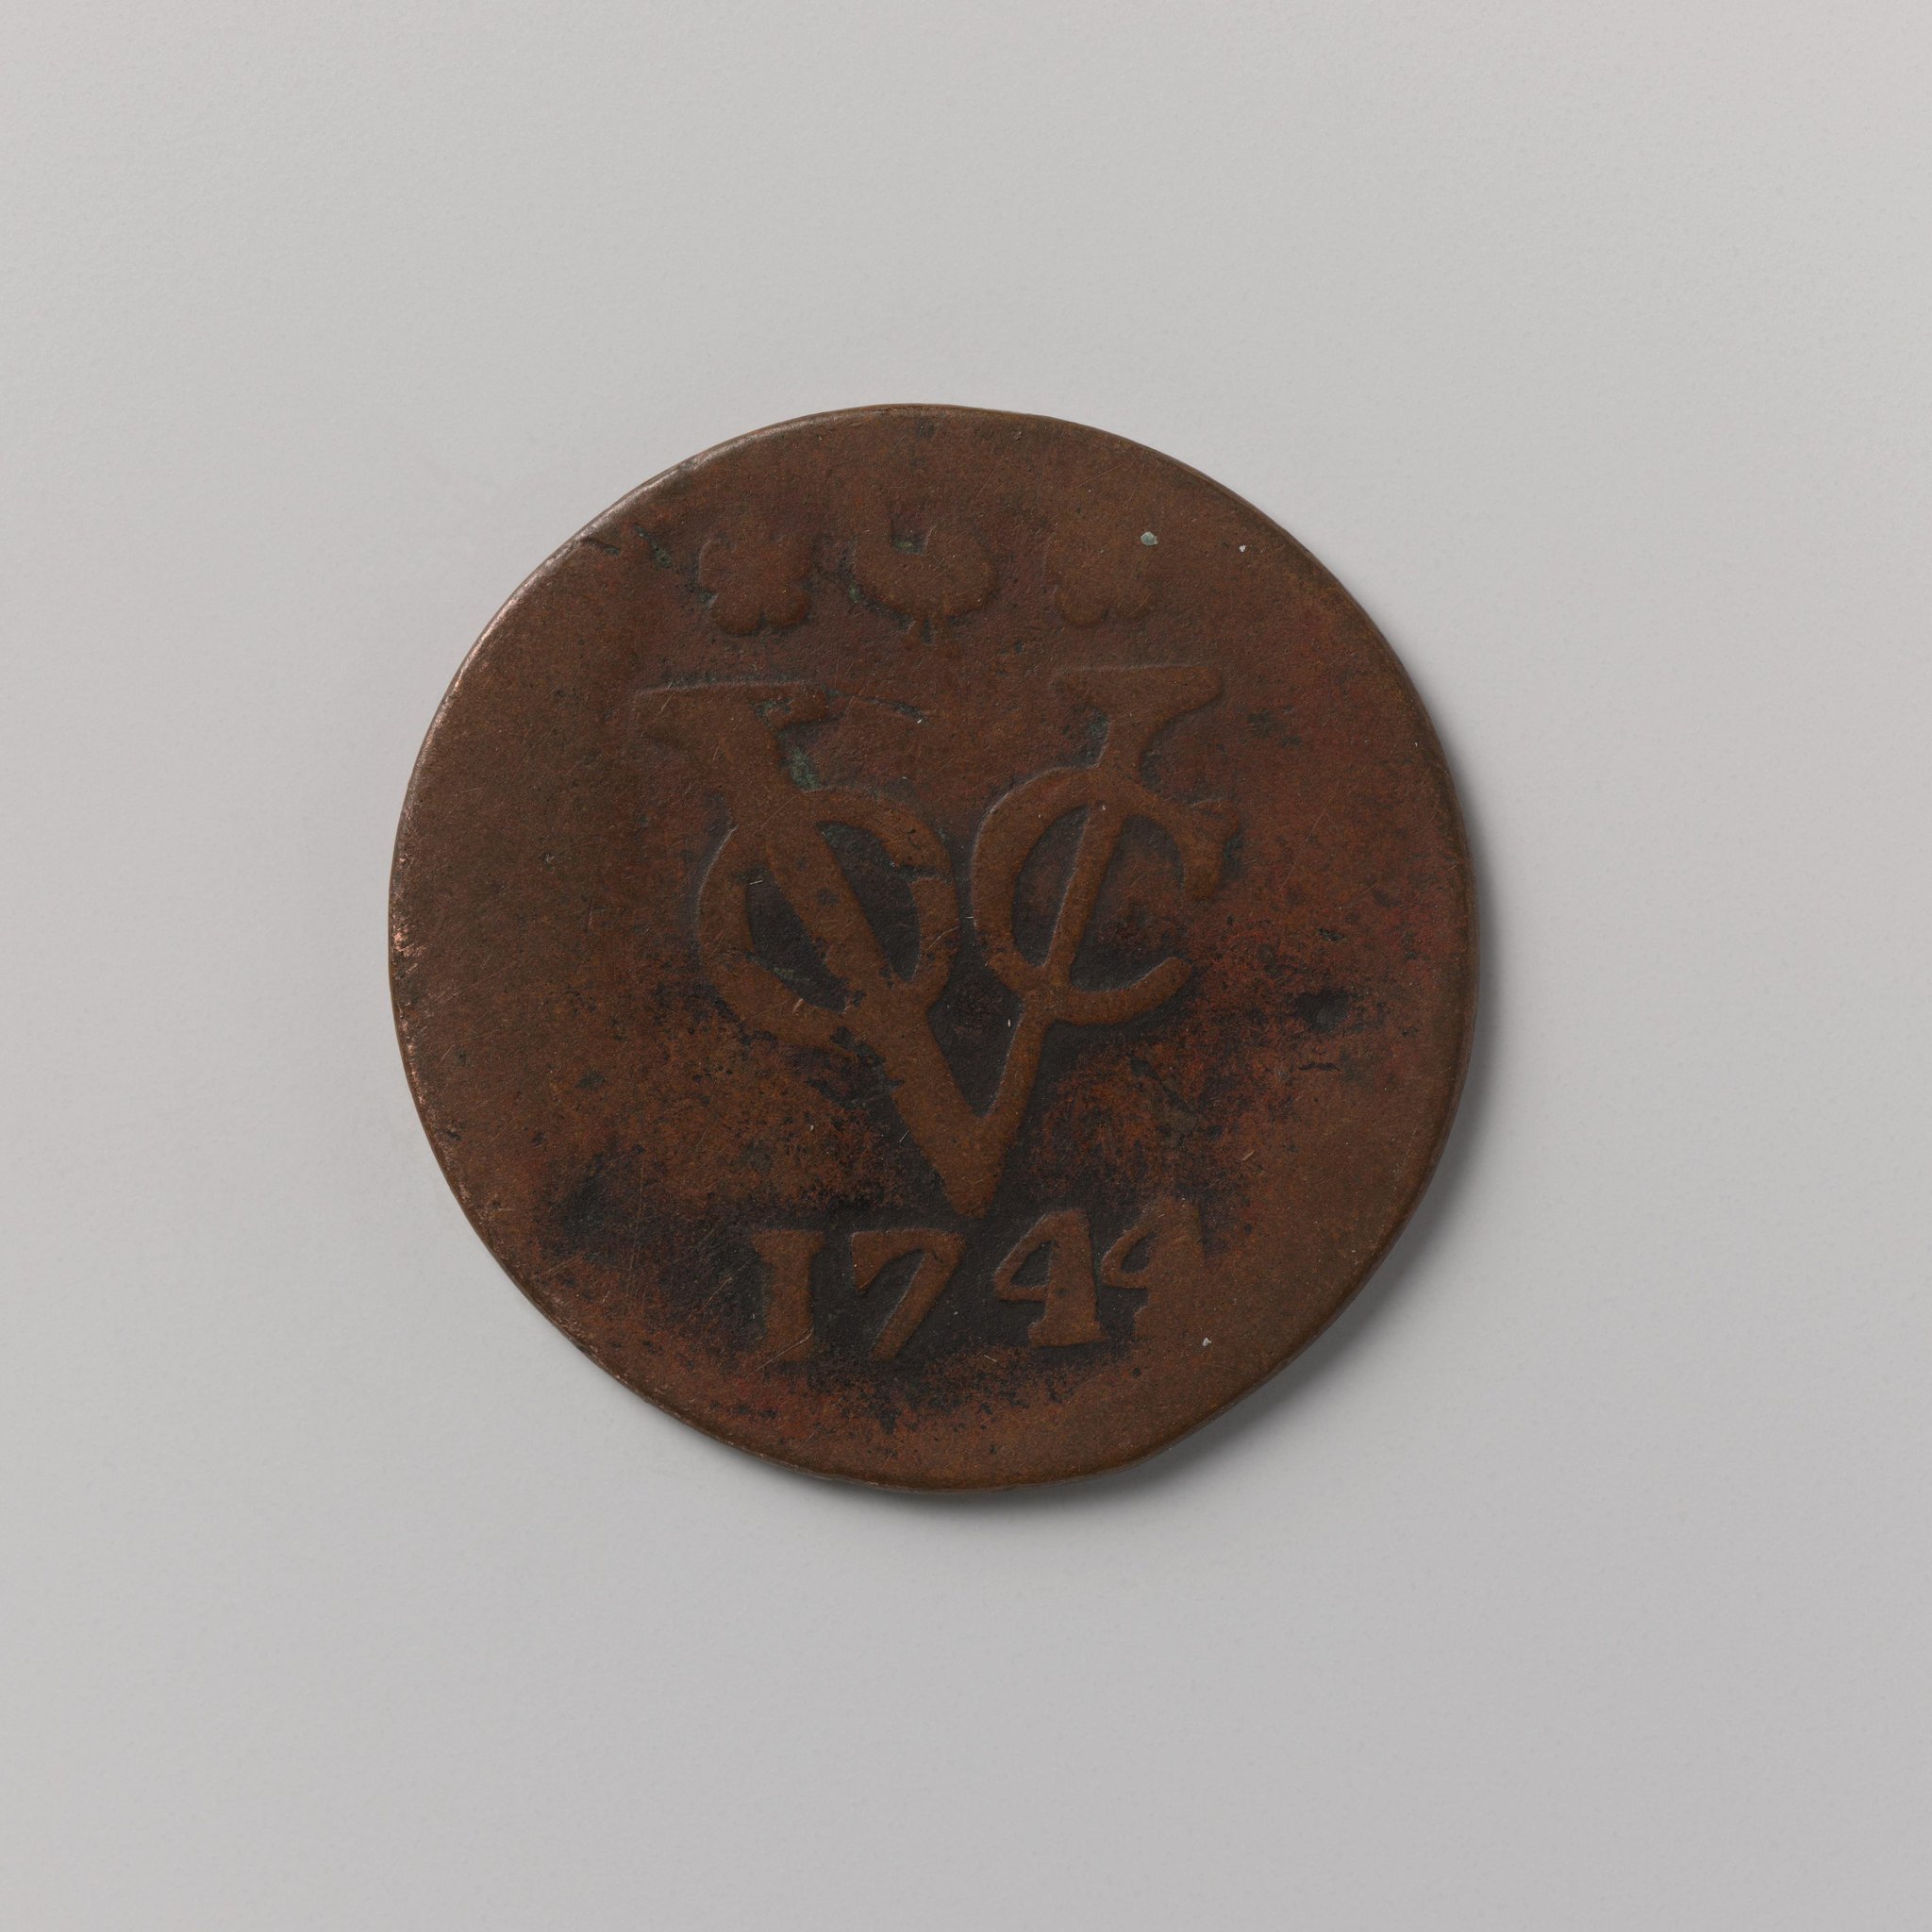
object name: coin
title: VOC, duit Westfriesland, 1744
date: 1744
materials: copper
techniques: striking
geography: medemblik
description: Koperen munt. Voorzijde: gekroond wapenschild van Westfriesland. Keerzijde: monogram van de VOC, waarboven muntmeesterteken en waaronder jaartal. Gladde rand.